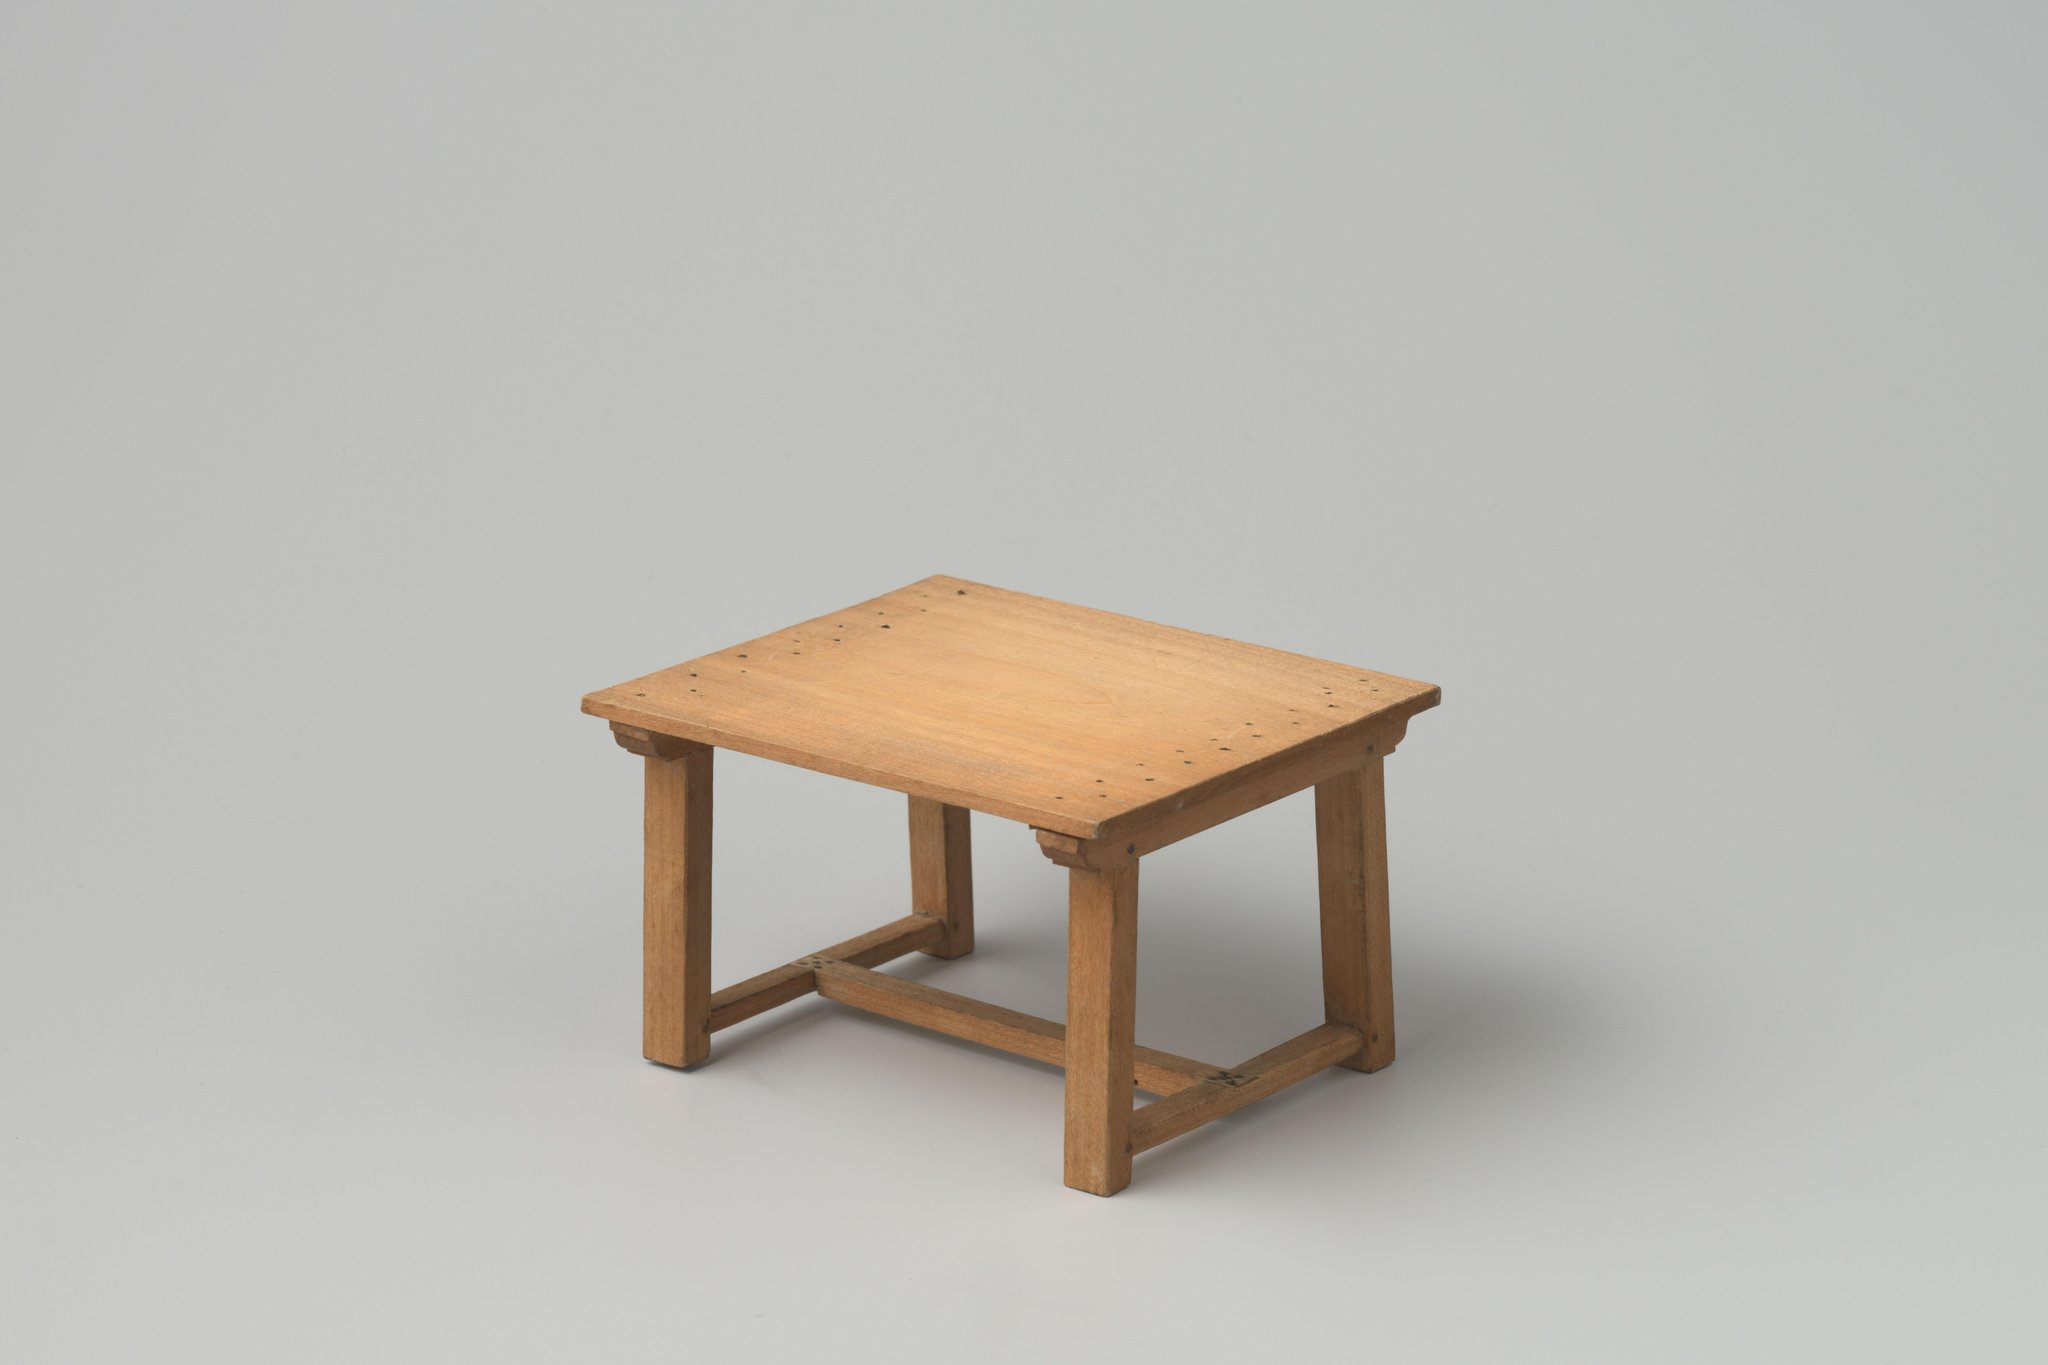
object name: miniature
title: Tafel vervaardigd van een without, waarop los liggend lessenaar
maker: Anonymous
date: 1690-1710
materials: iron, wood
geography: amsterdam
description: Tafel vervaardigd van een withoutsoort, waarop los liggend een lessenaar. Eenvoudige stevige tafel op vier iets schuin geplaatste vierkante poten, onderling verbonden door een H-vormig kruis. Verbindingen zijn verstevigd met houten en ijzeren pennen, het blad is op het onderstel vast gespijkerd met 14 zigzag geplaatste spijkertjes.